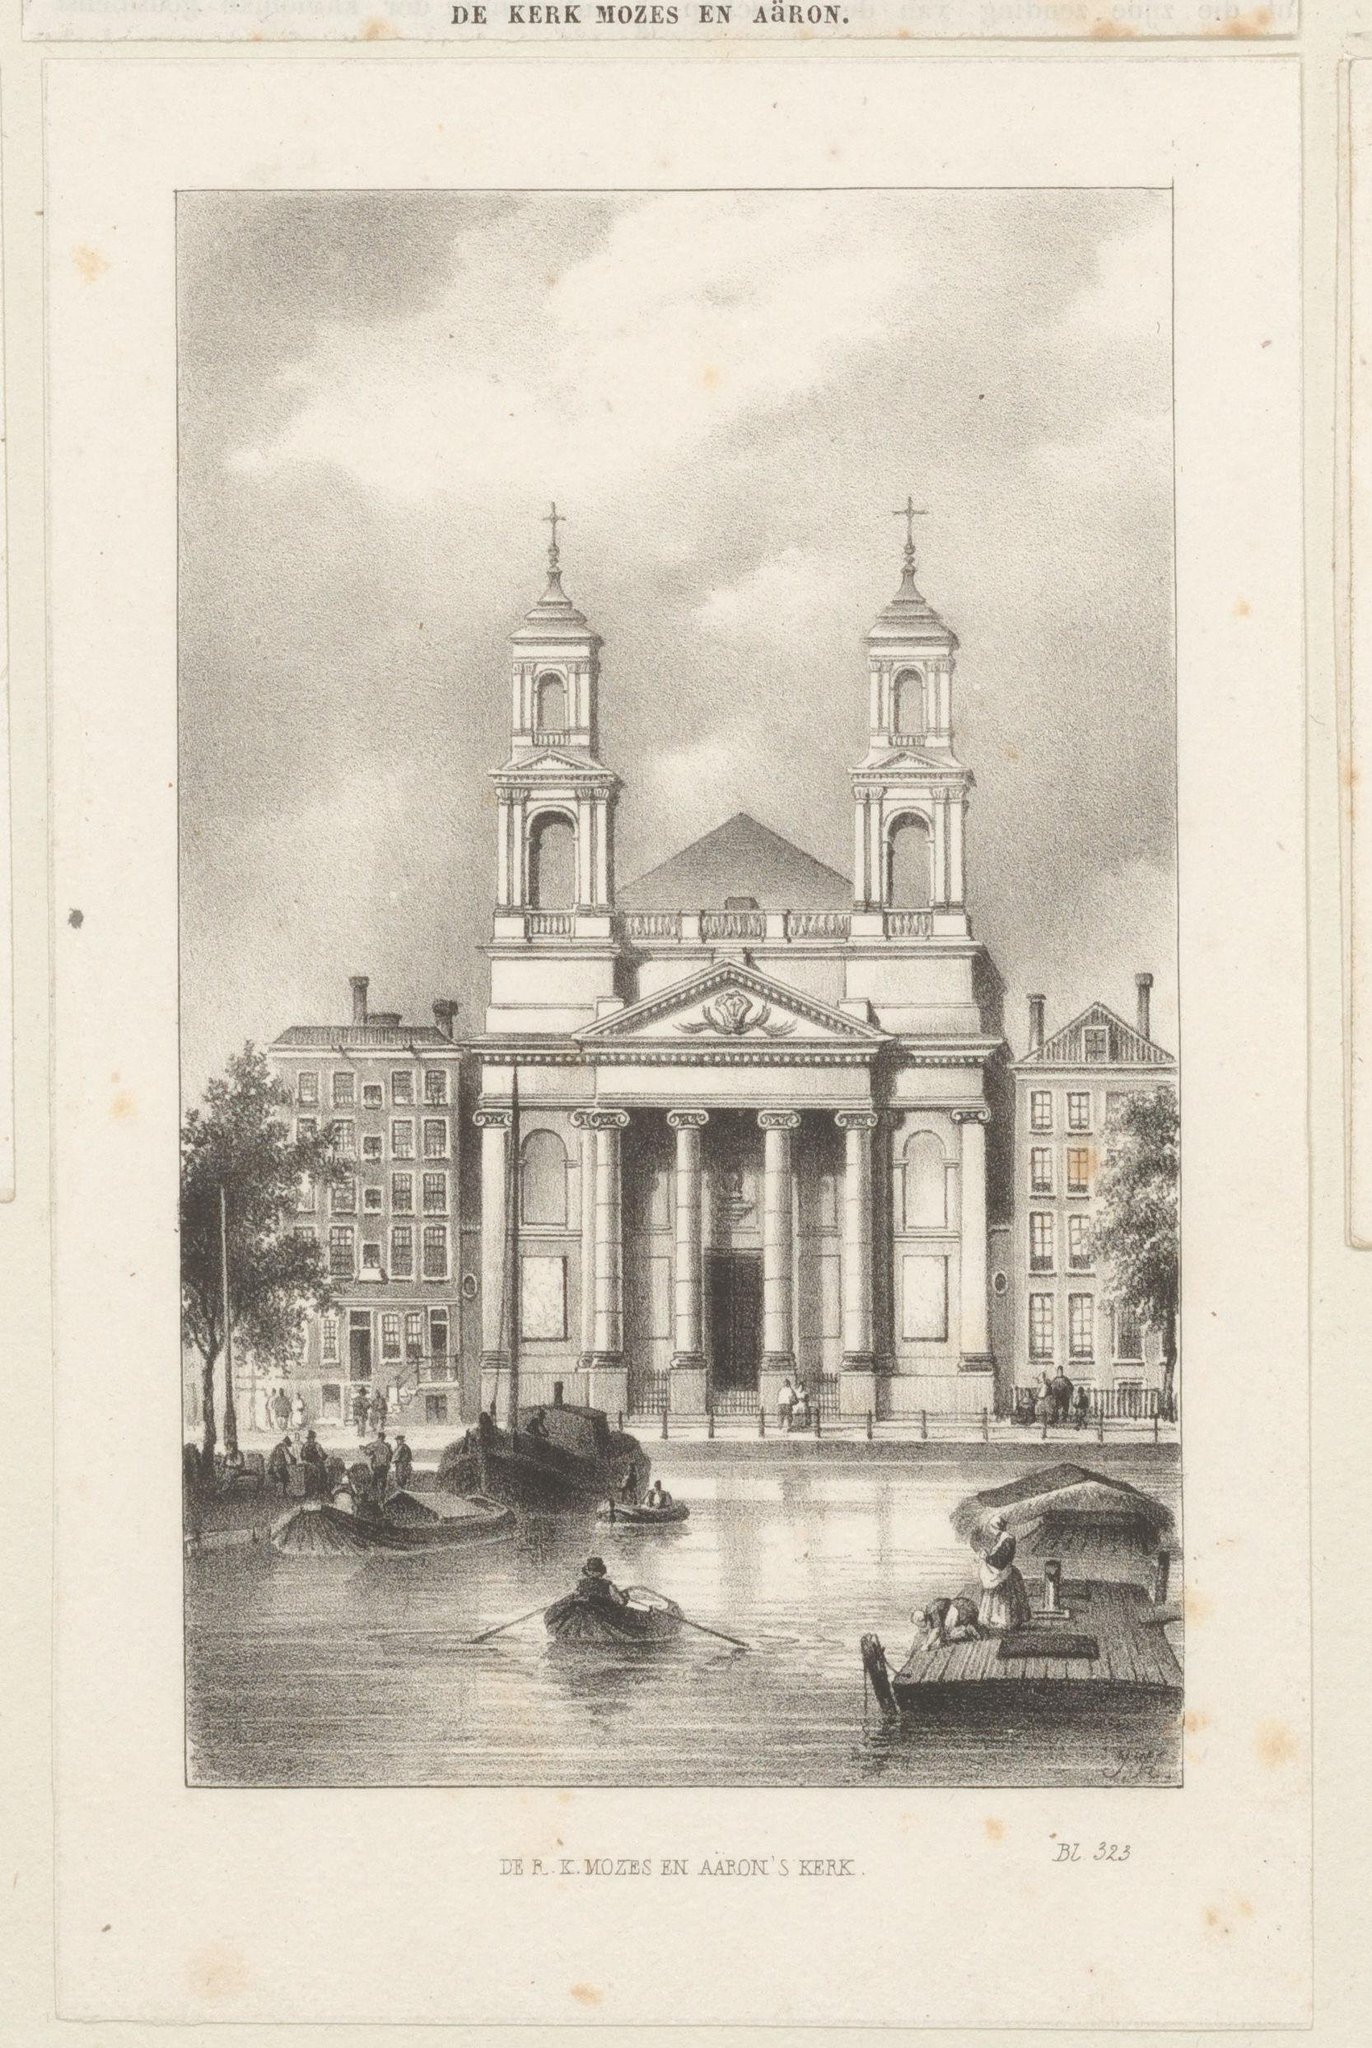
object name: print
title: Gezicht op de Mozes en Aäronkerk te Amsterdam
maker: johannes hilverdink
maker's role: draughtsman, painter, print maker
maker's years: 1813-1902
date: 1844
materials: paper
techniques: lithograph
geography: netherlands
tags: church (exterior), canals, waters (in city) (+ city(-scape) with figures, staffage)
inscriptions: collector's mark: Lugt 1641b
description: Prent uit: Vijver, Cornelis van der. Geschiedkundige Beschrijving der Stad Amsterdam (...). Amsterdam: Gebroeders Diederichs, 1844, dl. 1.